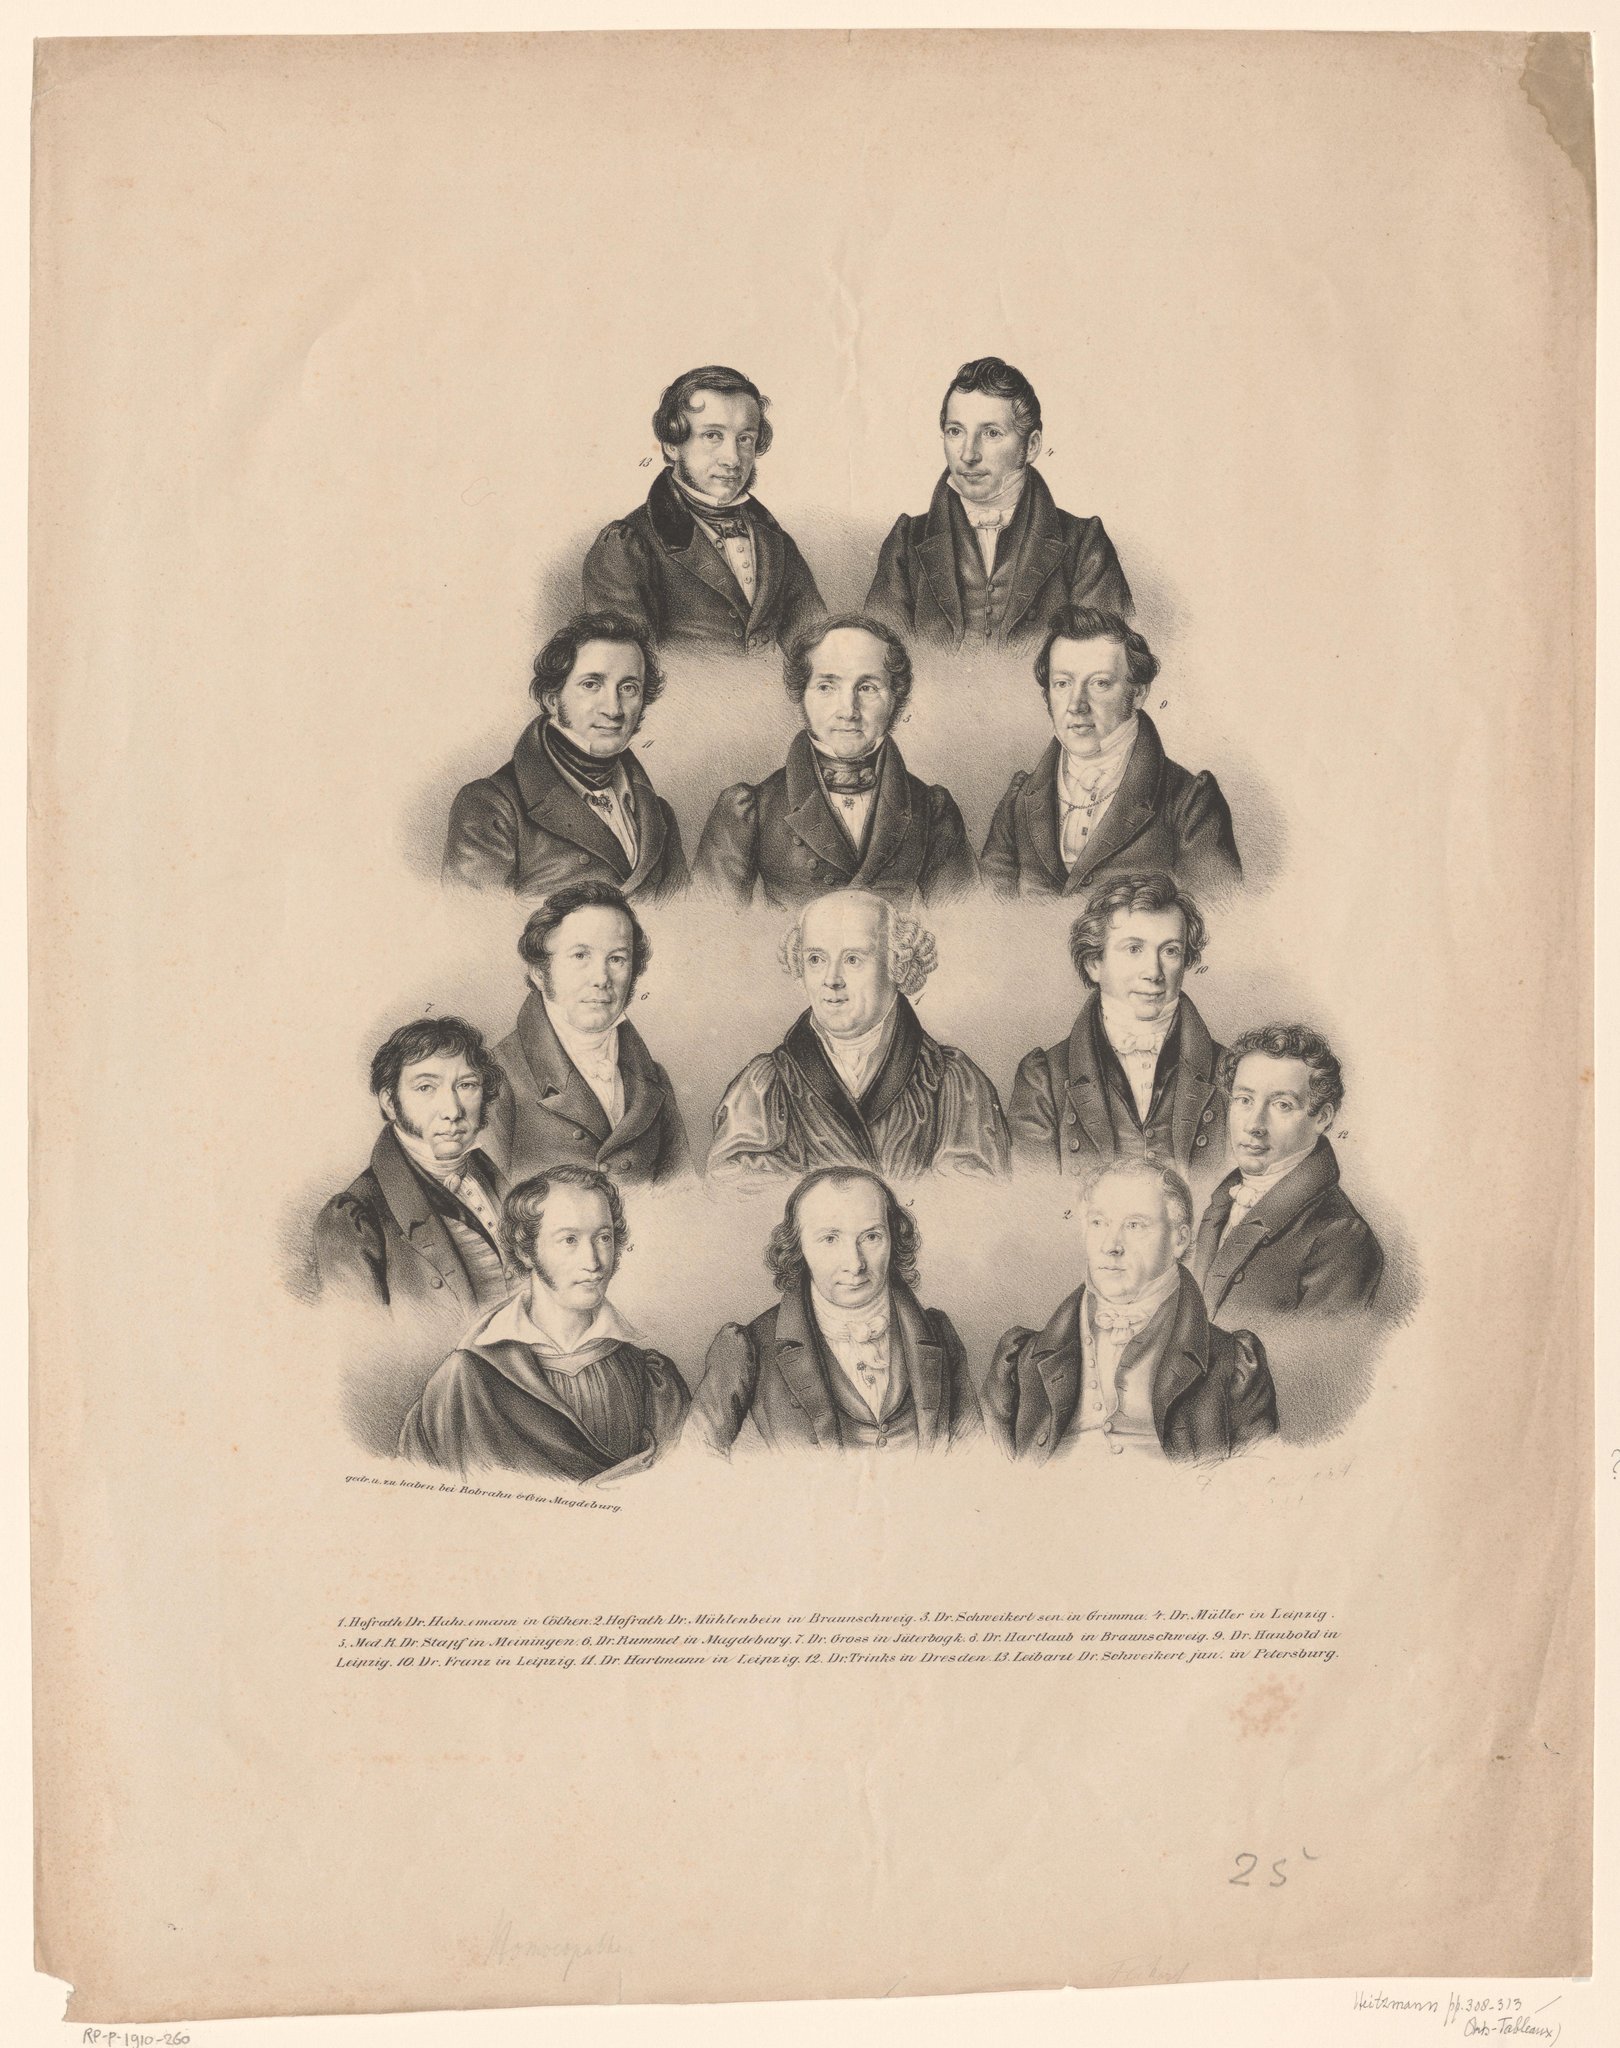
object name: print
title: Portretten van dertien homeopaten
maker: Anonymous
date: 1823-1856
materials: paper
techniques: lithograph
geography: magdeburg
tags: historical persons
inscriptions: collector's mark: Lugt 2228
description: Portretten van Samuel Hahnemann, Georg August Heinrich Mühlenbein, Julius Schweikert, Moritz Wilhelm Muller, Johann Ernst Stapf, Friedrich Jacob Rummel, Gustav Wilhelm Gross, Carl Georg Christian Hartlaub, Carl Haubold, Johann Georg Friedrich Franz, Franz Hartmann, Carl Friedrich Trinks en Julius Schweikert.